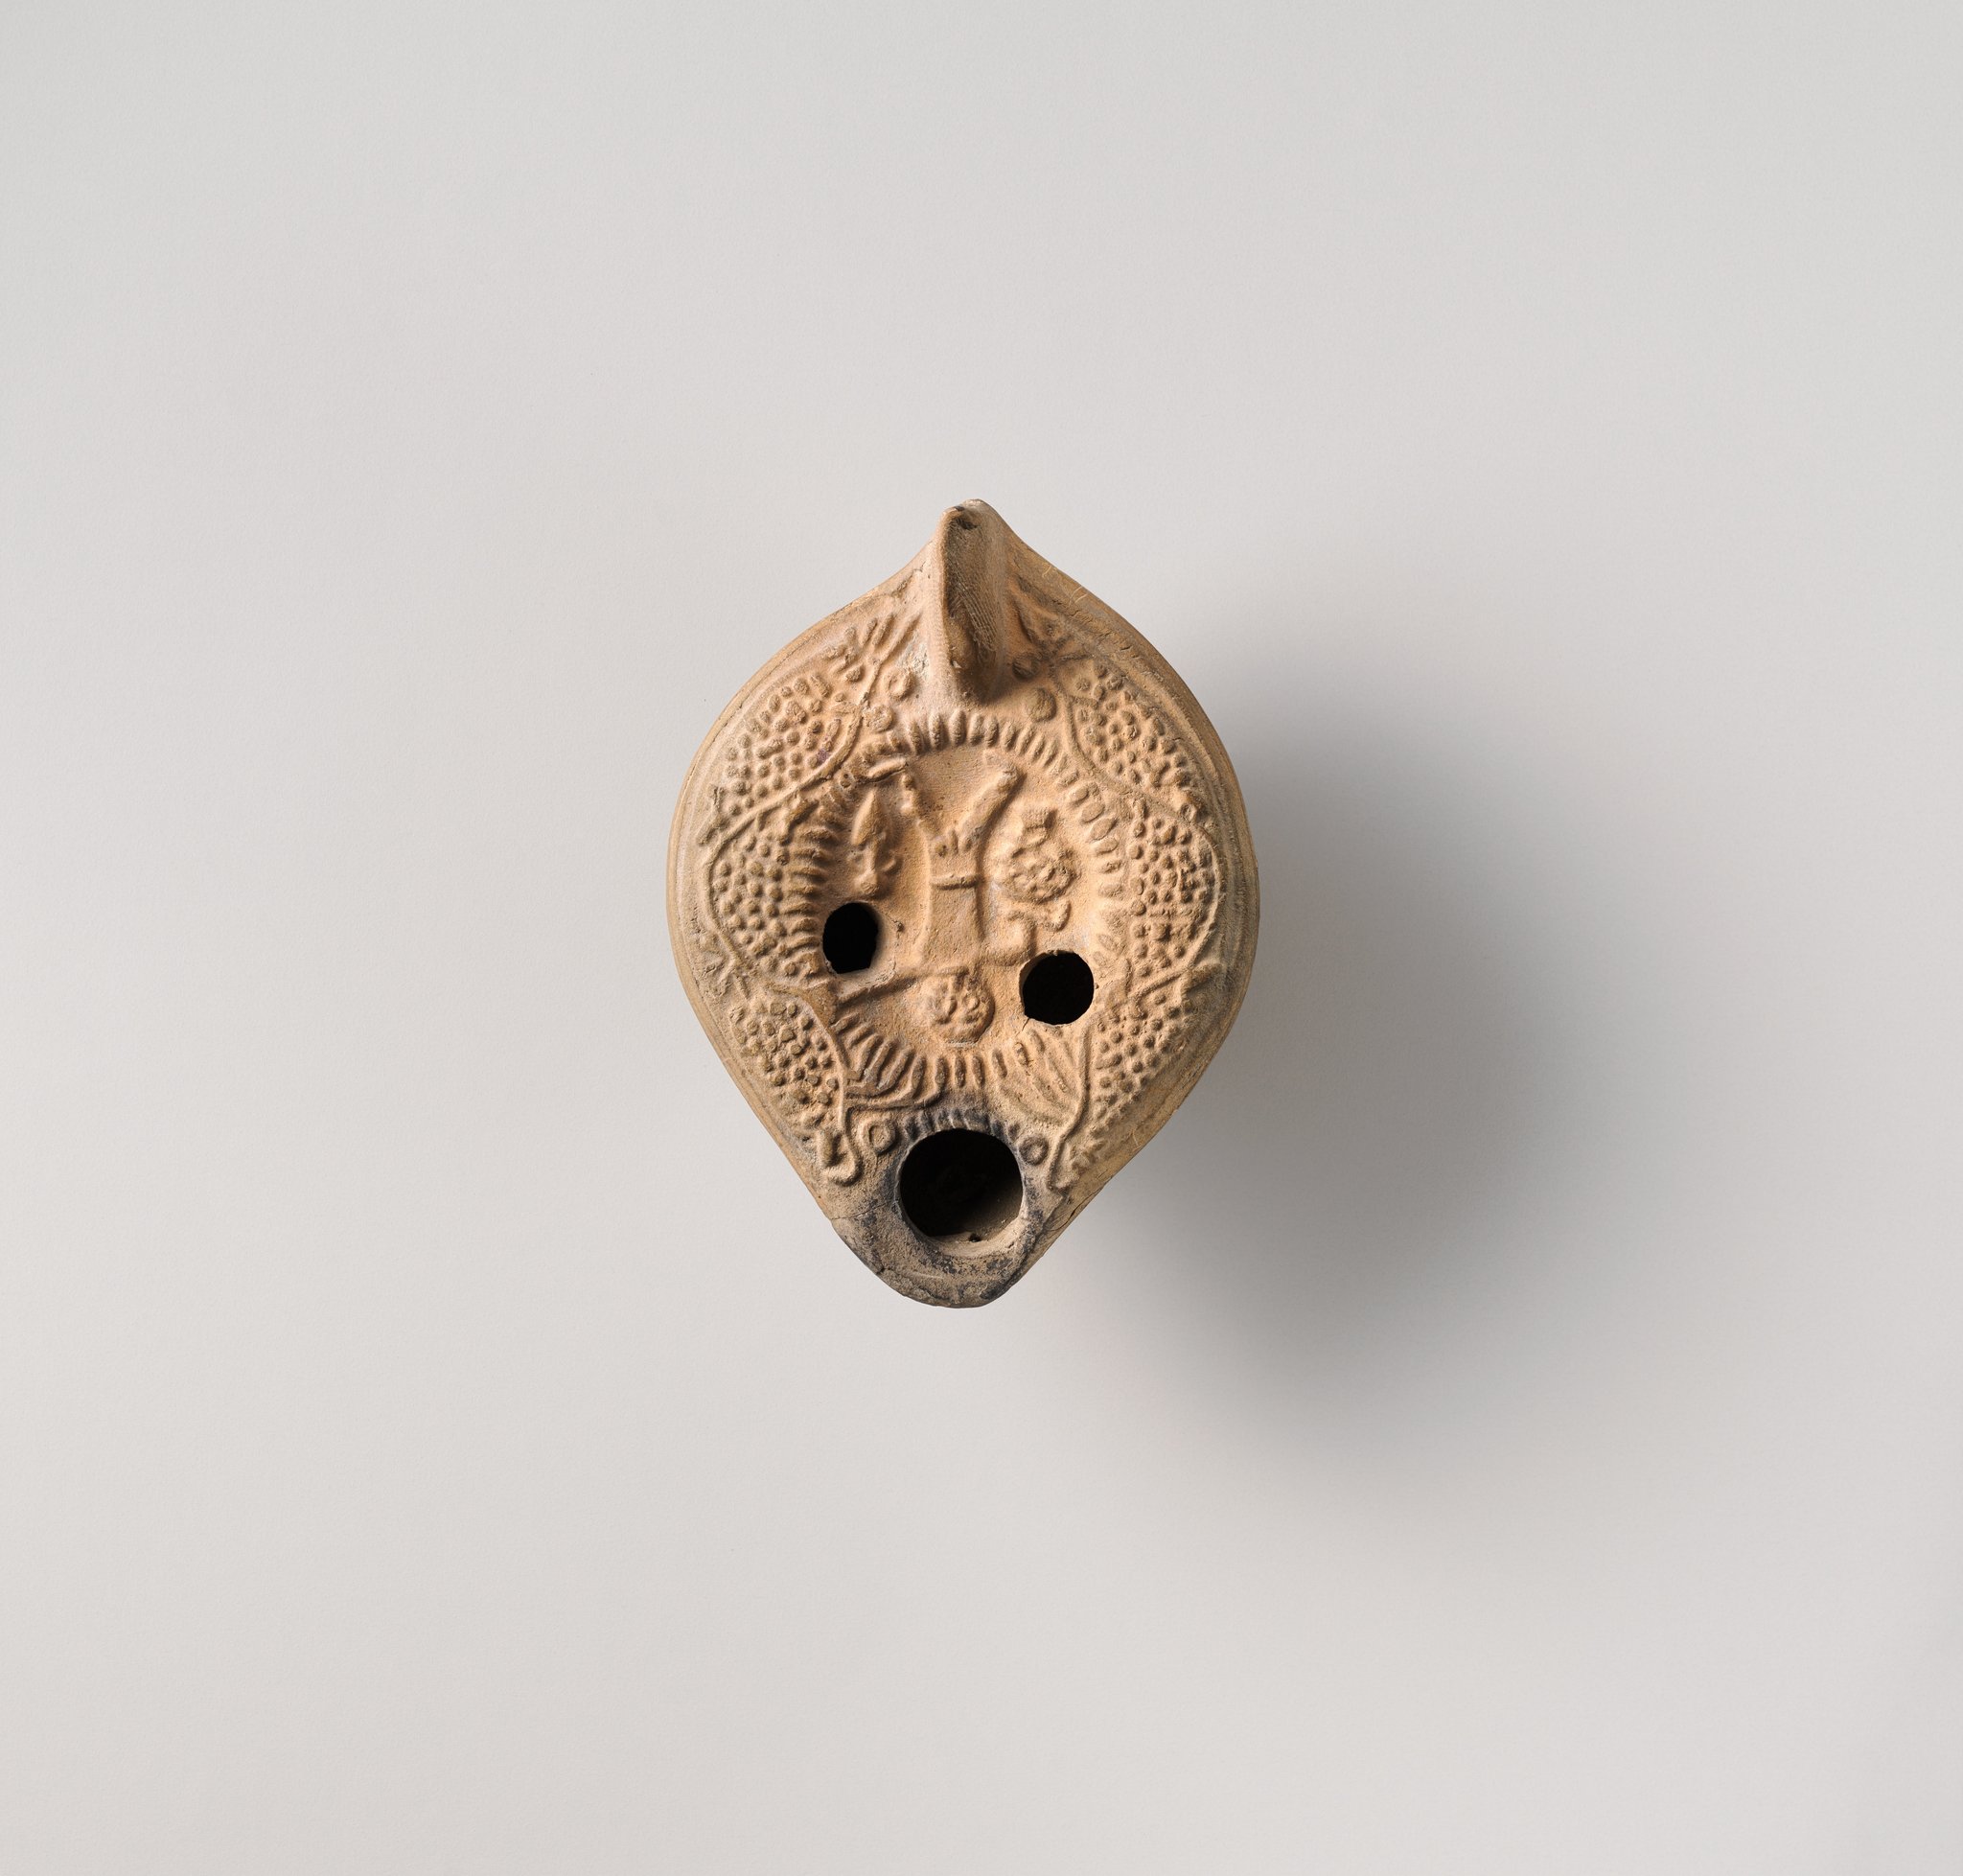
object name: lamp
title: Terracotta oil lamp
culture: roman, cypriot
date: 201-400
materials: terracotta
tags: men